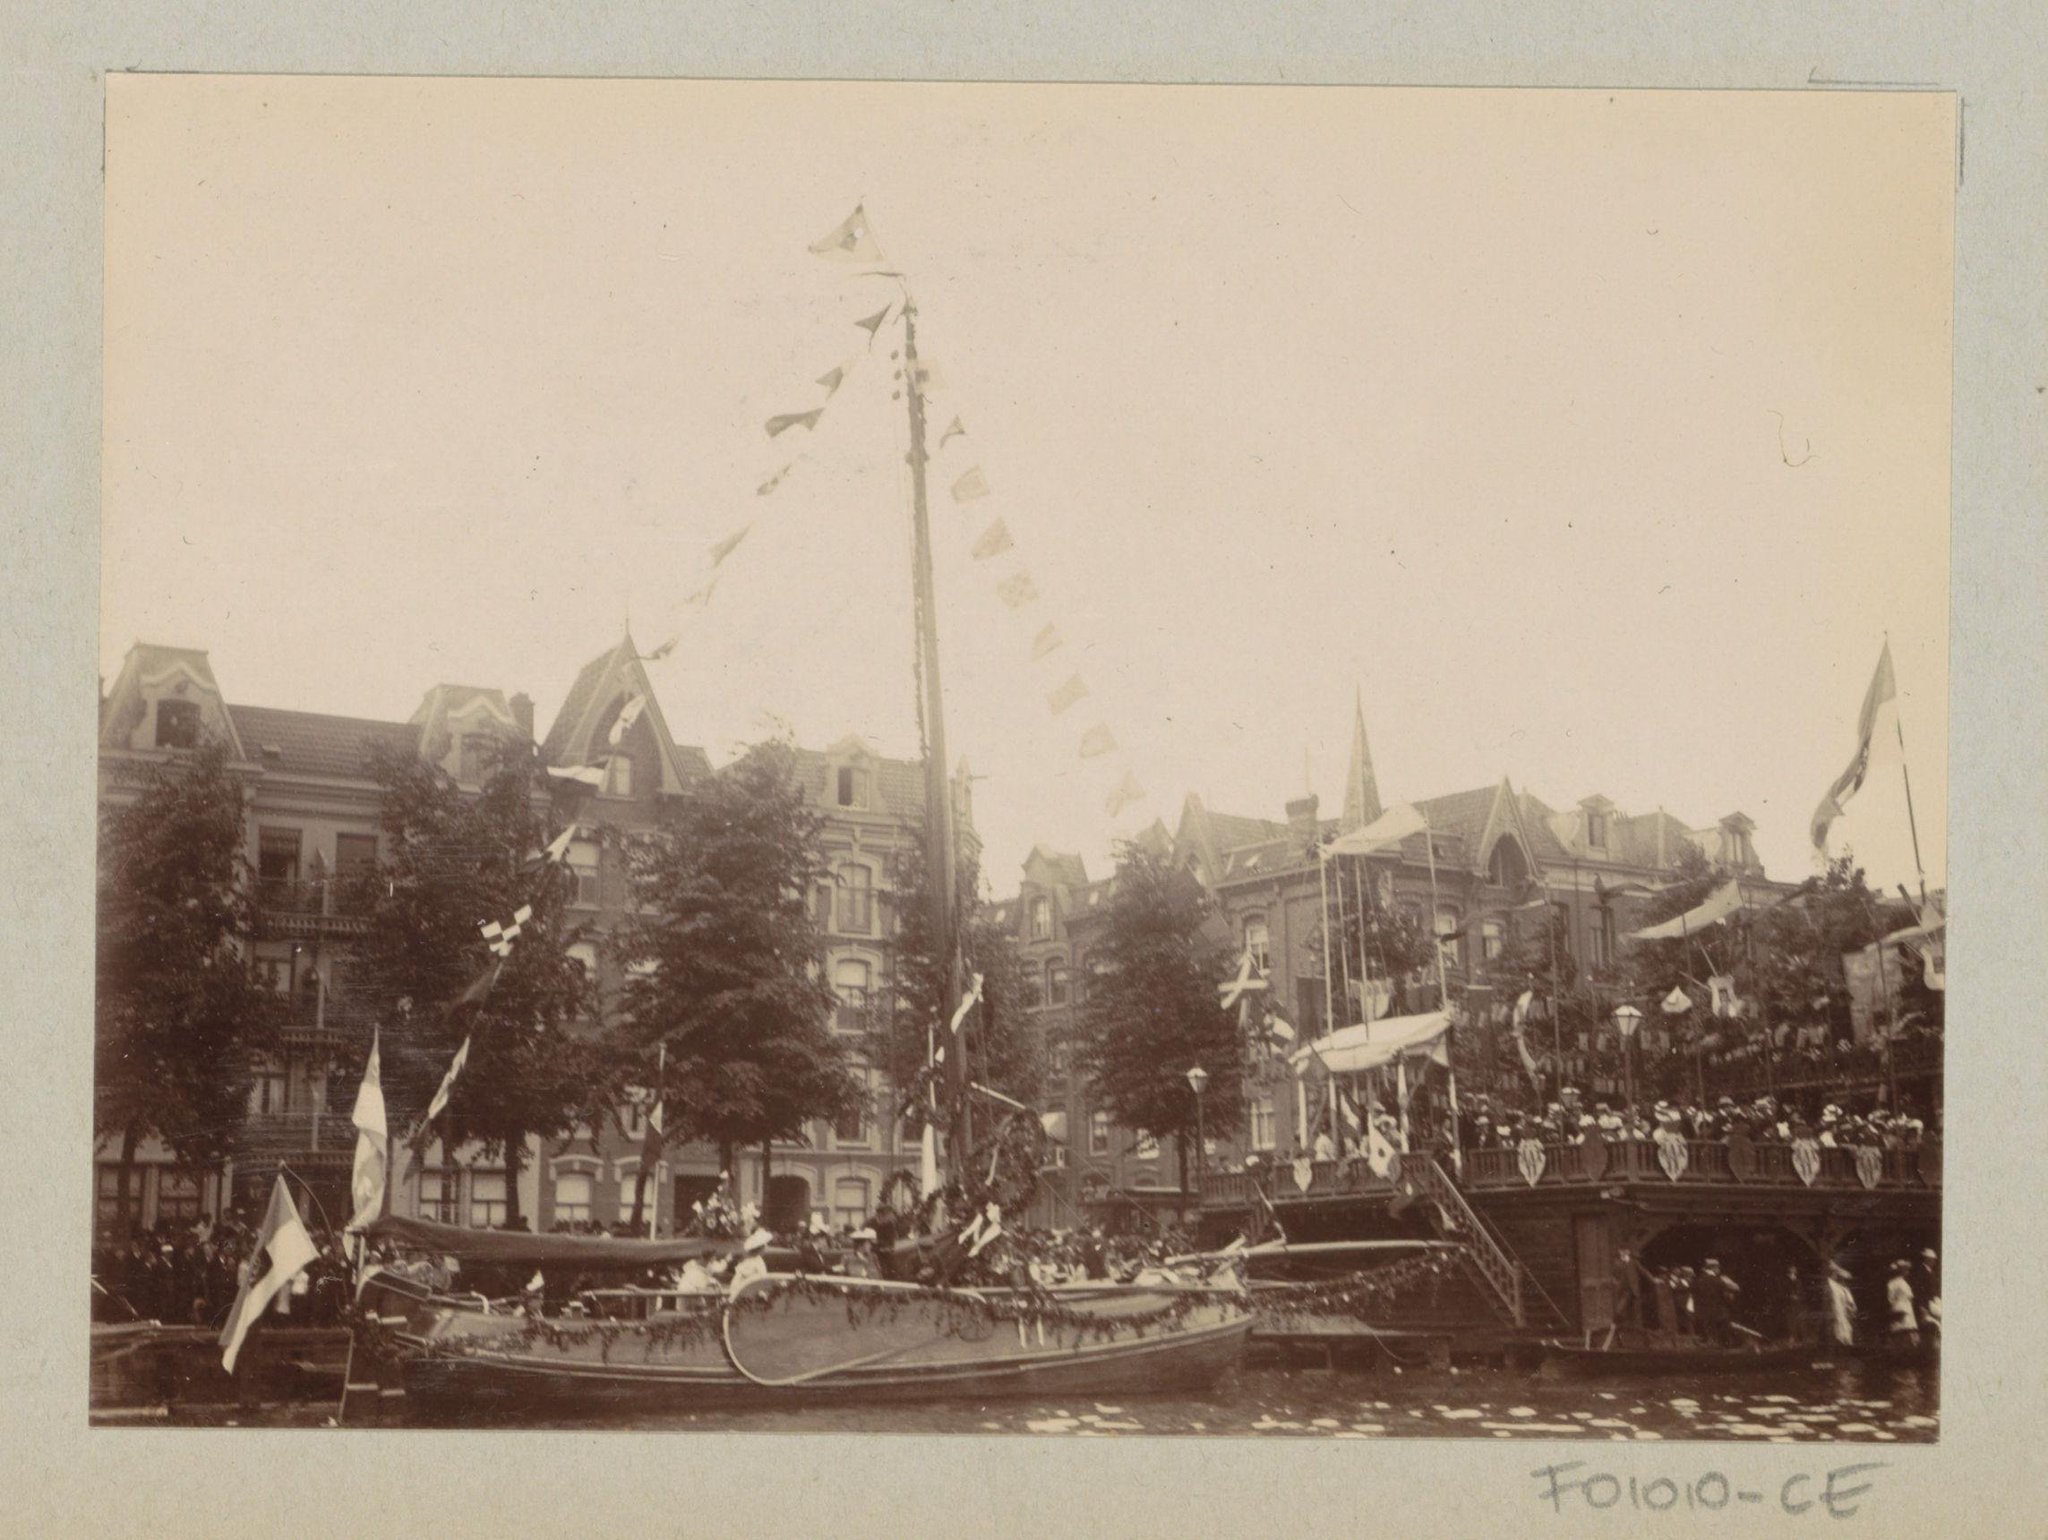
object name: photograph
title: Versierde boten aan de Amsteldijk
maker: Anonymous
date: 1906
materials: photographic support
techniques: gelatin silver print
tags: river, commemoration, jubilee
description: Onderdeel van Familiealbum met onder meer foto's van Wijnhandel Kraaij & Co. Bordeaux-Amsterdam.